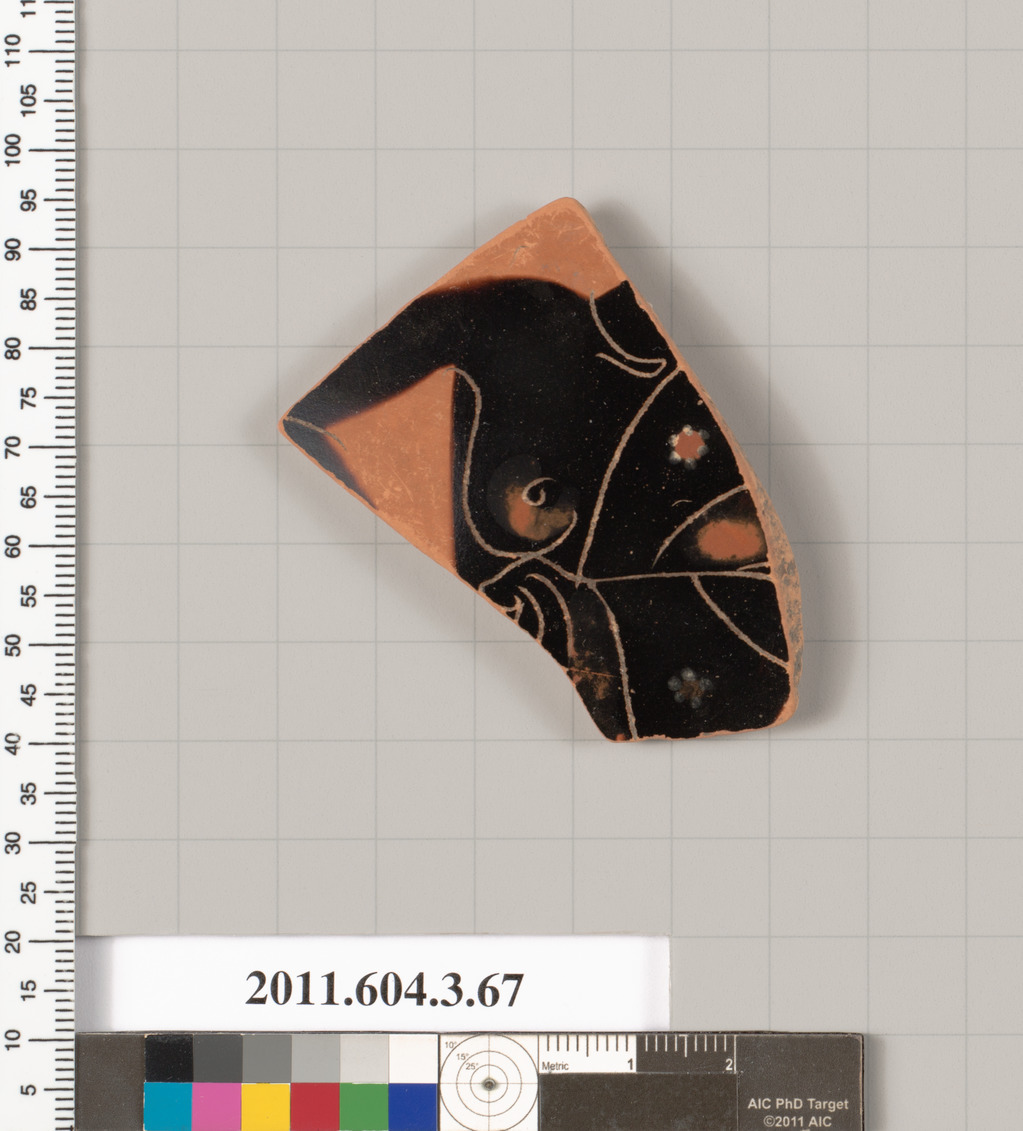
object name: amphora fragment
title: Terracotta fragment of an amphora (jar)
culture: greek, attic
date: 525-501 BCE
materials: terracotta